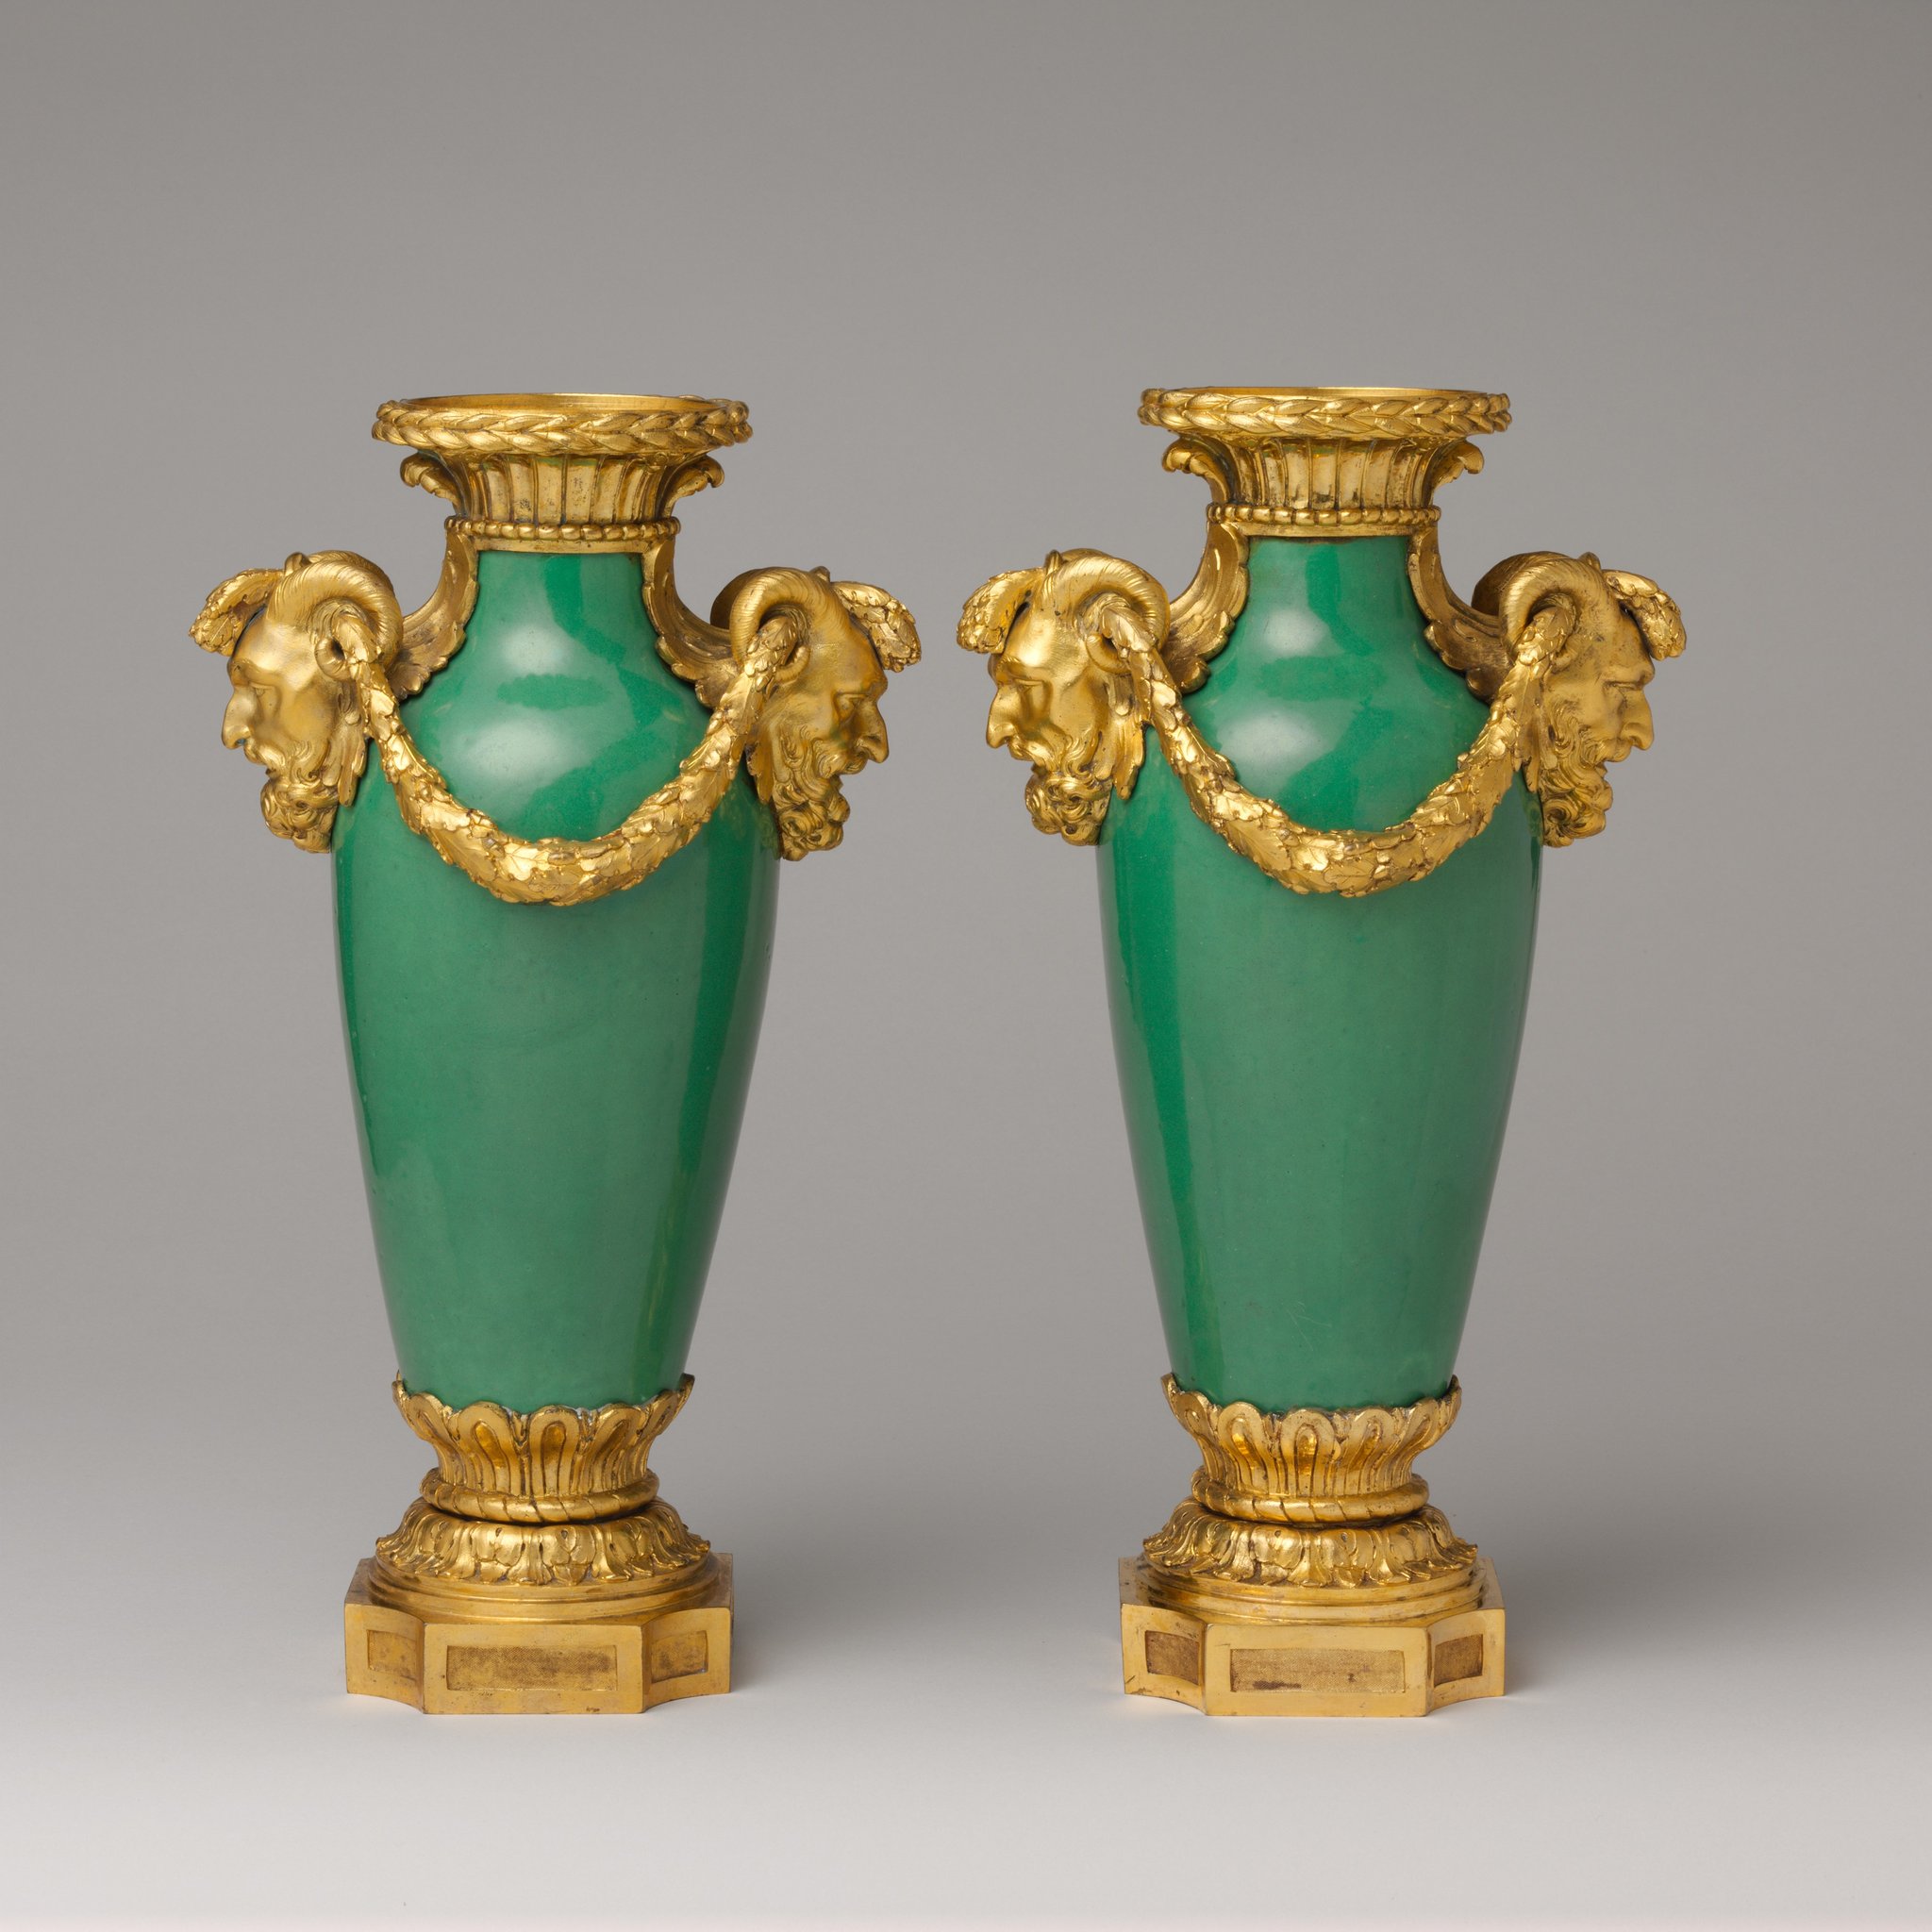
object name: vase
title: Pair of mounted vases (vase à monter)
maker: sèvres manufactory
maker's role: manufactory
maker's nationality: french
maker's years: 1740-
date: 1765-1770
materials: gilt bronze, soft paste porcelain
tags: garlands,satyrs